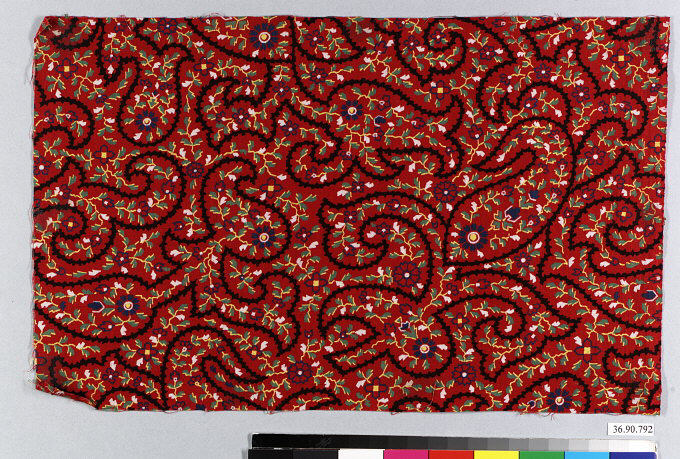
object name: piece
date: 1867-1900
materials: cotton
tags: flowers,leaves